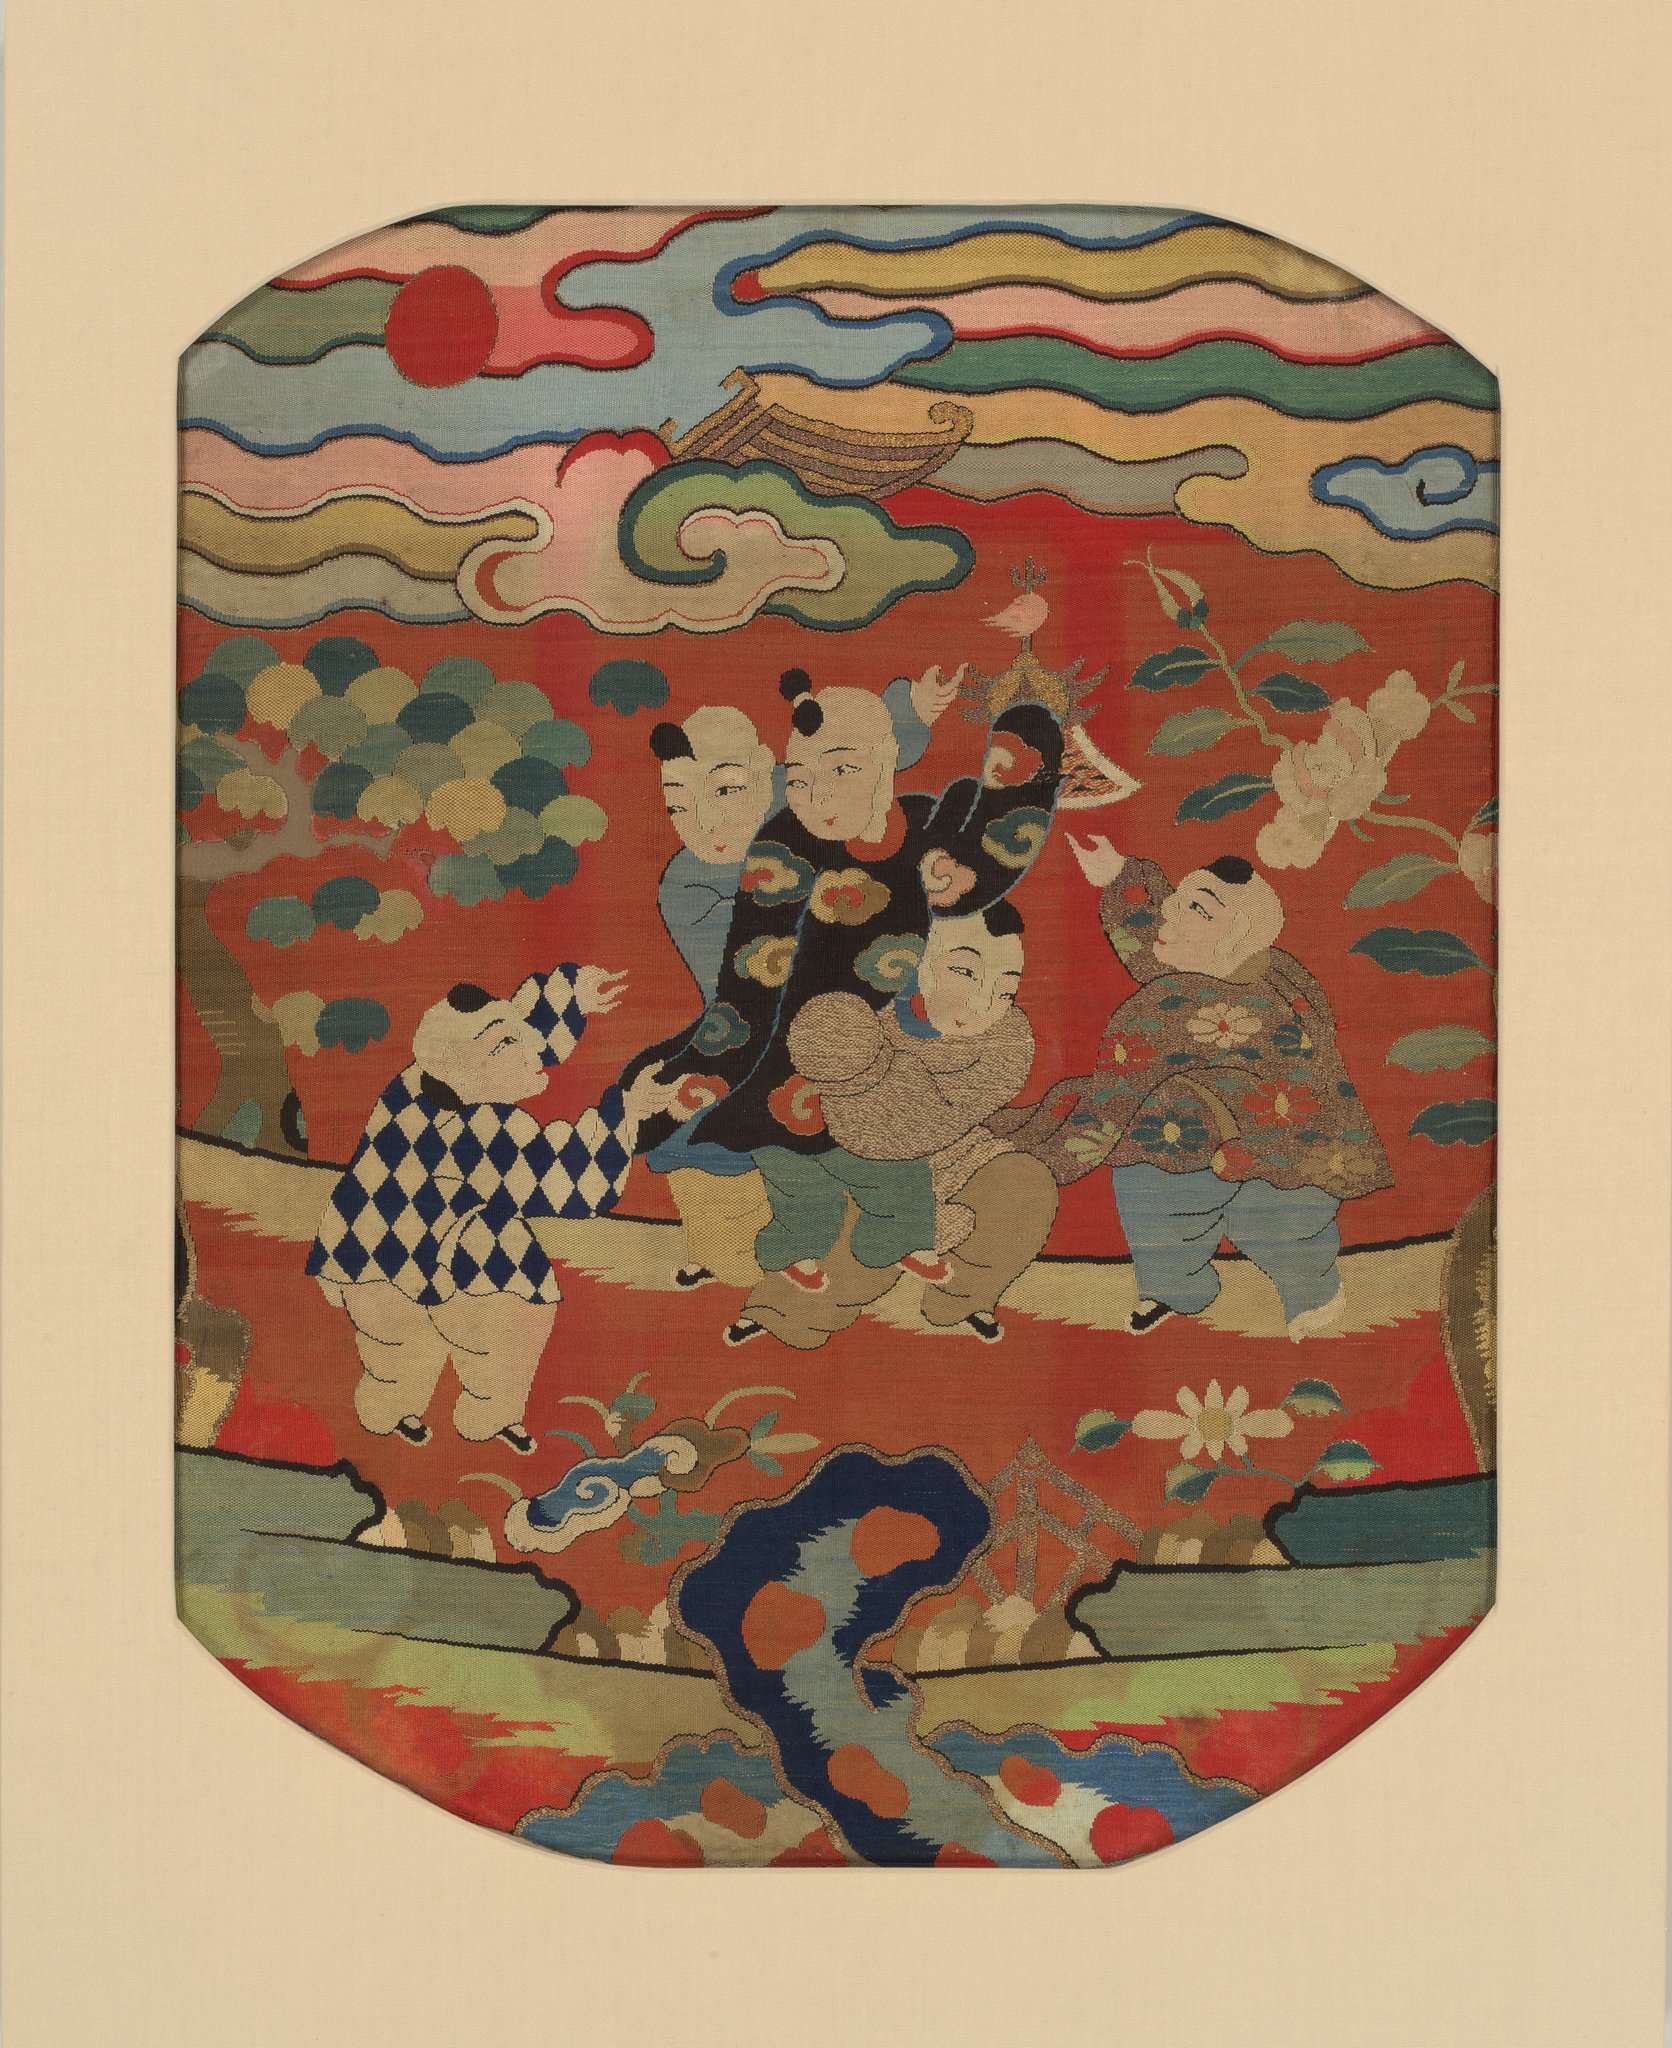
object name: panel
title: Panel with boys at play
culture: chinese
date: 1567-1633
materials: metal thread, silk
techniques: tapestry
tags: boys,playing